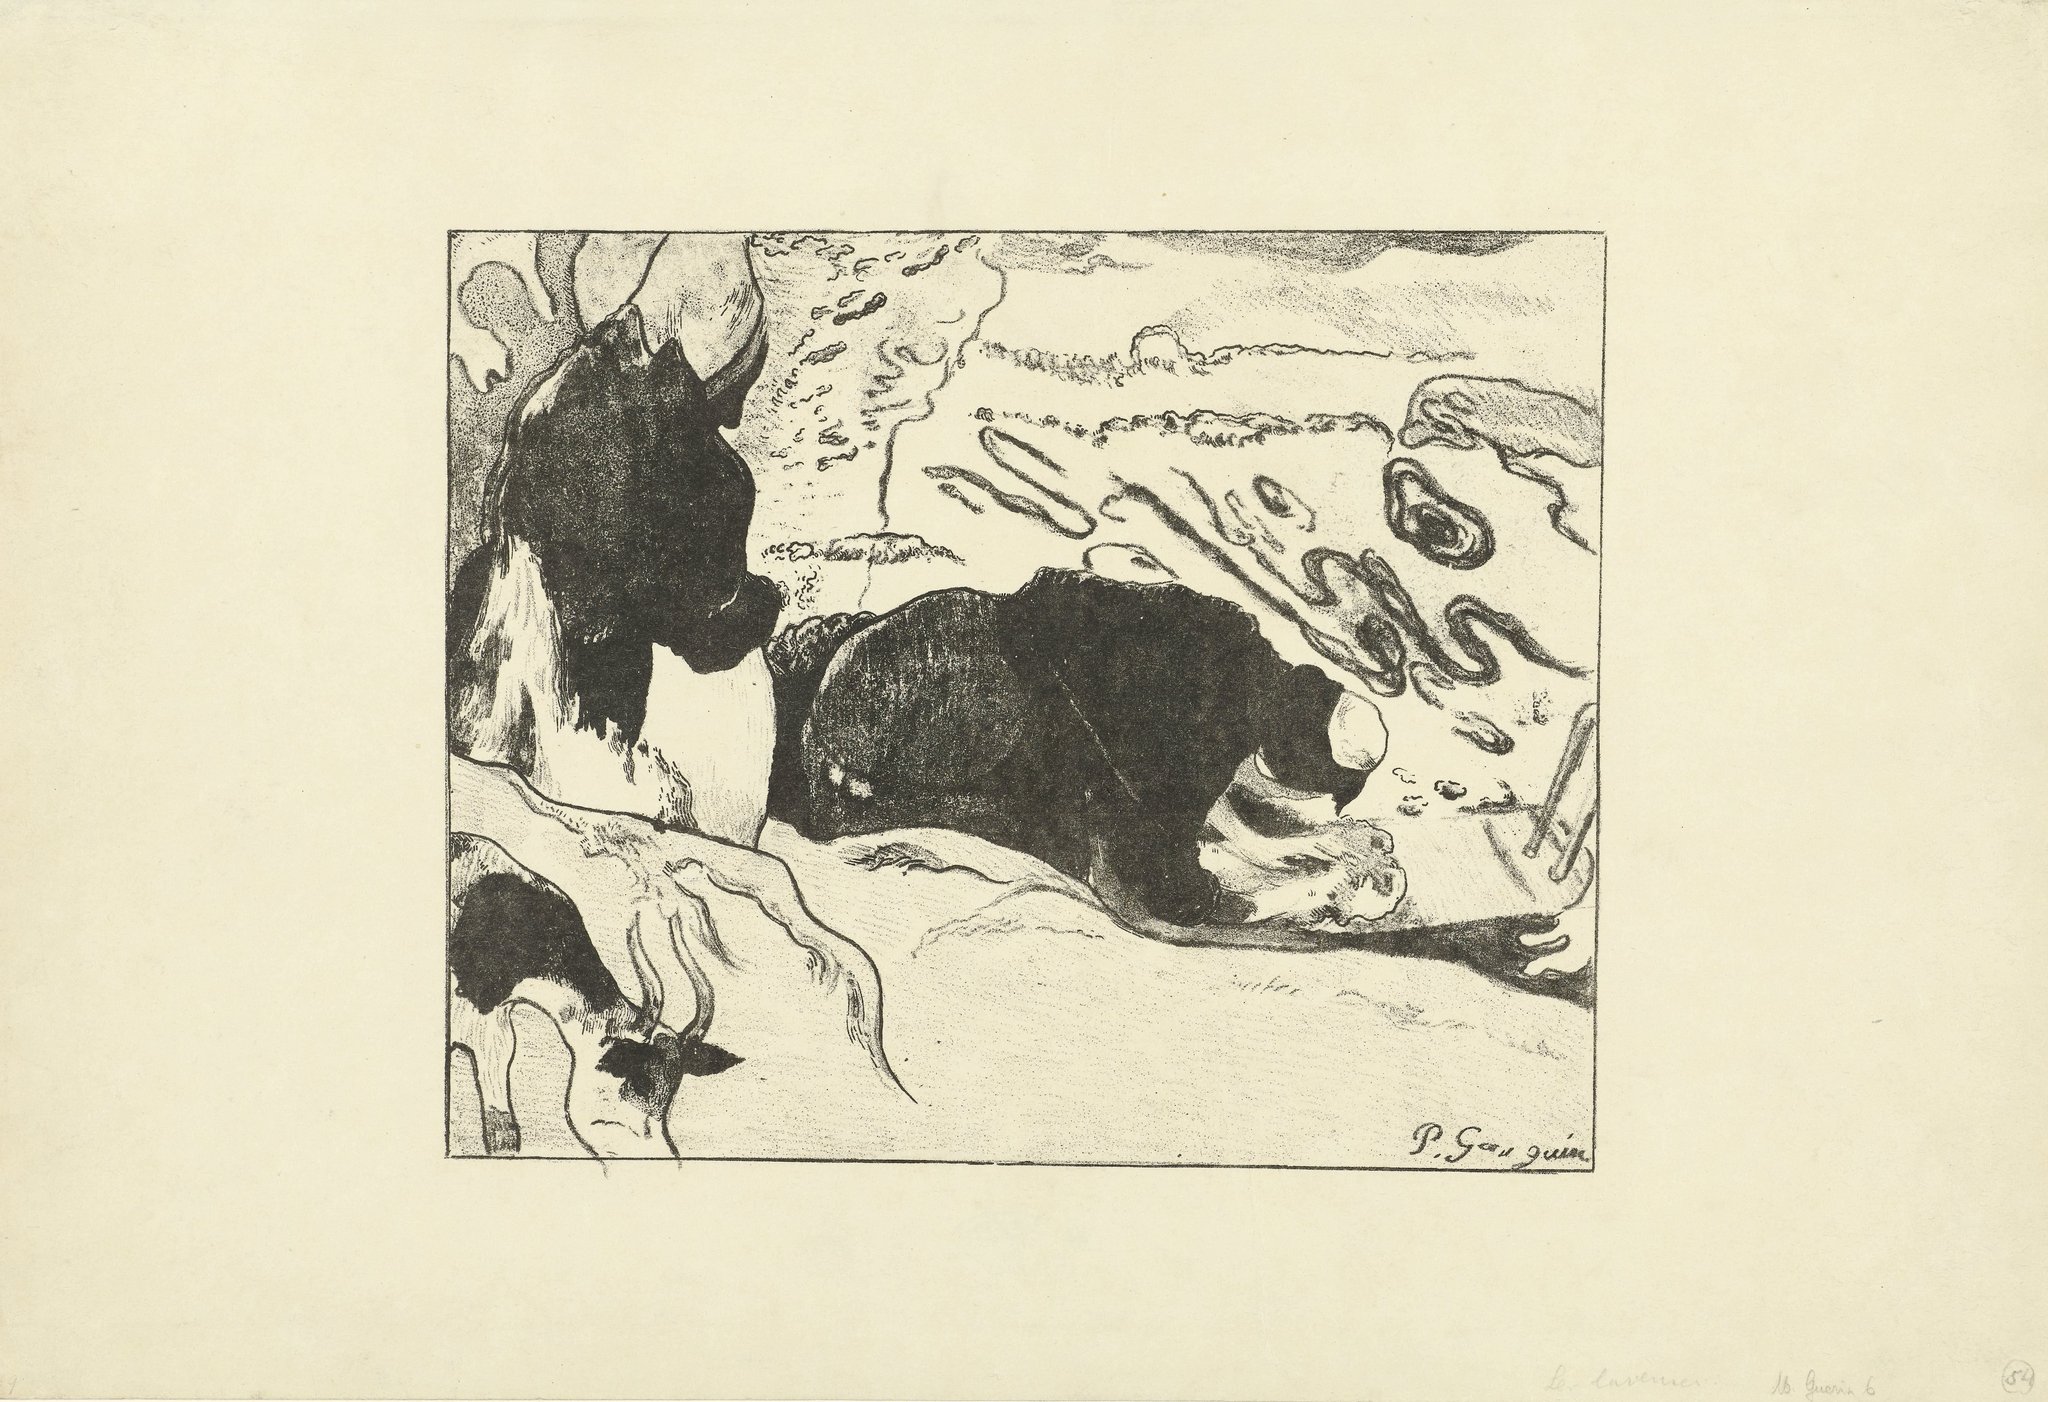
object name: print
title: Twee wasvrouwen wassen kleding bij water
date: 1889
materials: paper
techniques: lithography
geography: paris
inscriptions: collector's mark: Lugt 2760, collector's mark: Lugt 2228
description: Deze prent werd na 1900 uitgegeven door Ambroise Vollard in een oplage van ongeveer vijfitg exemplaren.